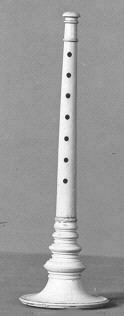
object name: pī chawā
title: Pī Chawā (ปี่ชวา)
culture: thai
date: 1867-1900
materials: ivory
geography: thailand